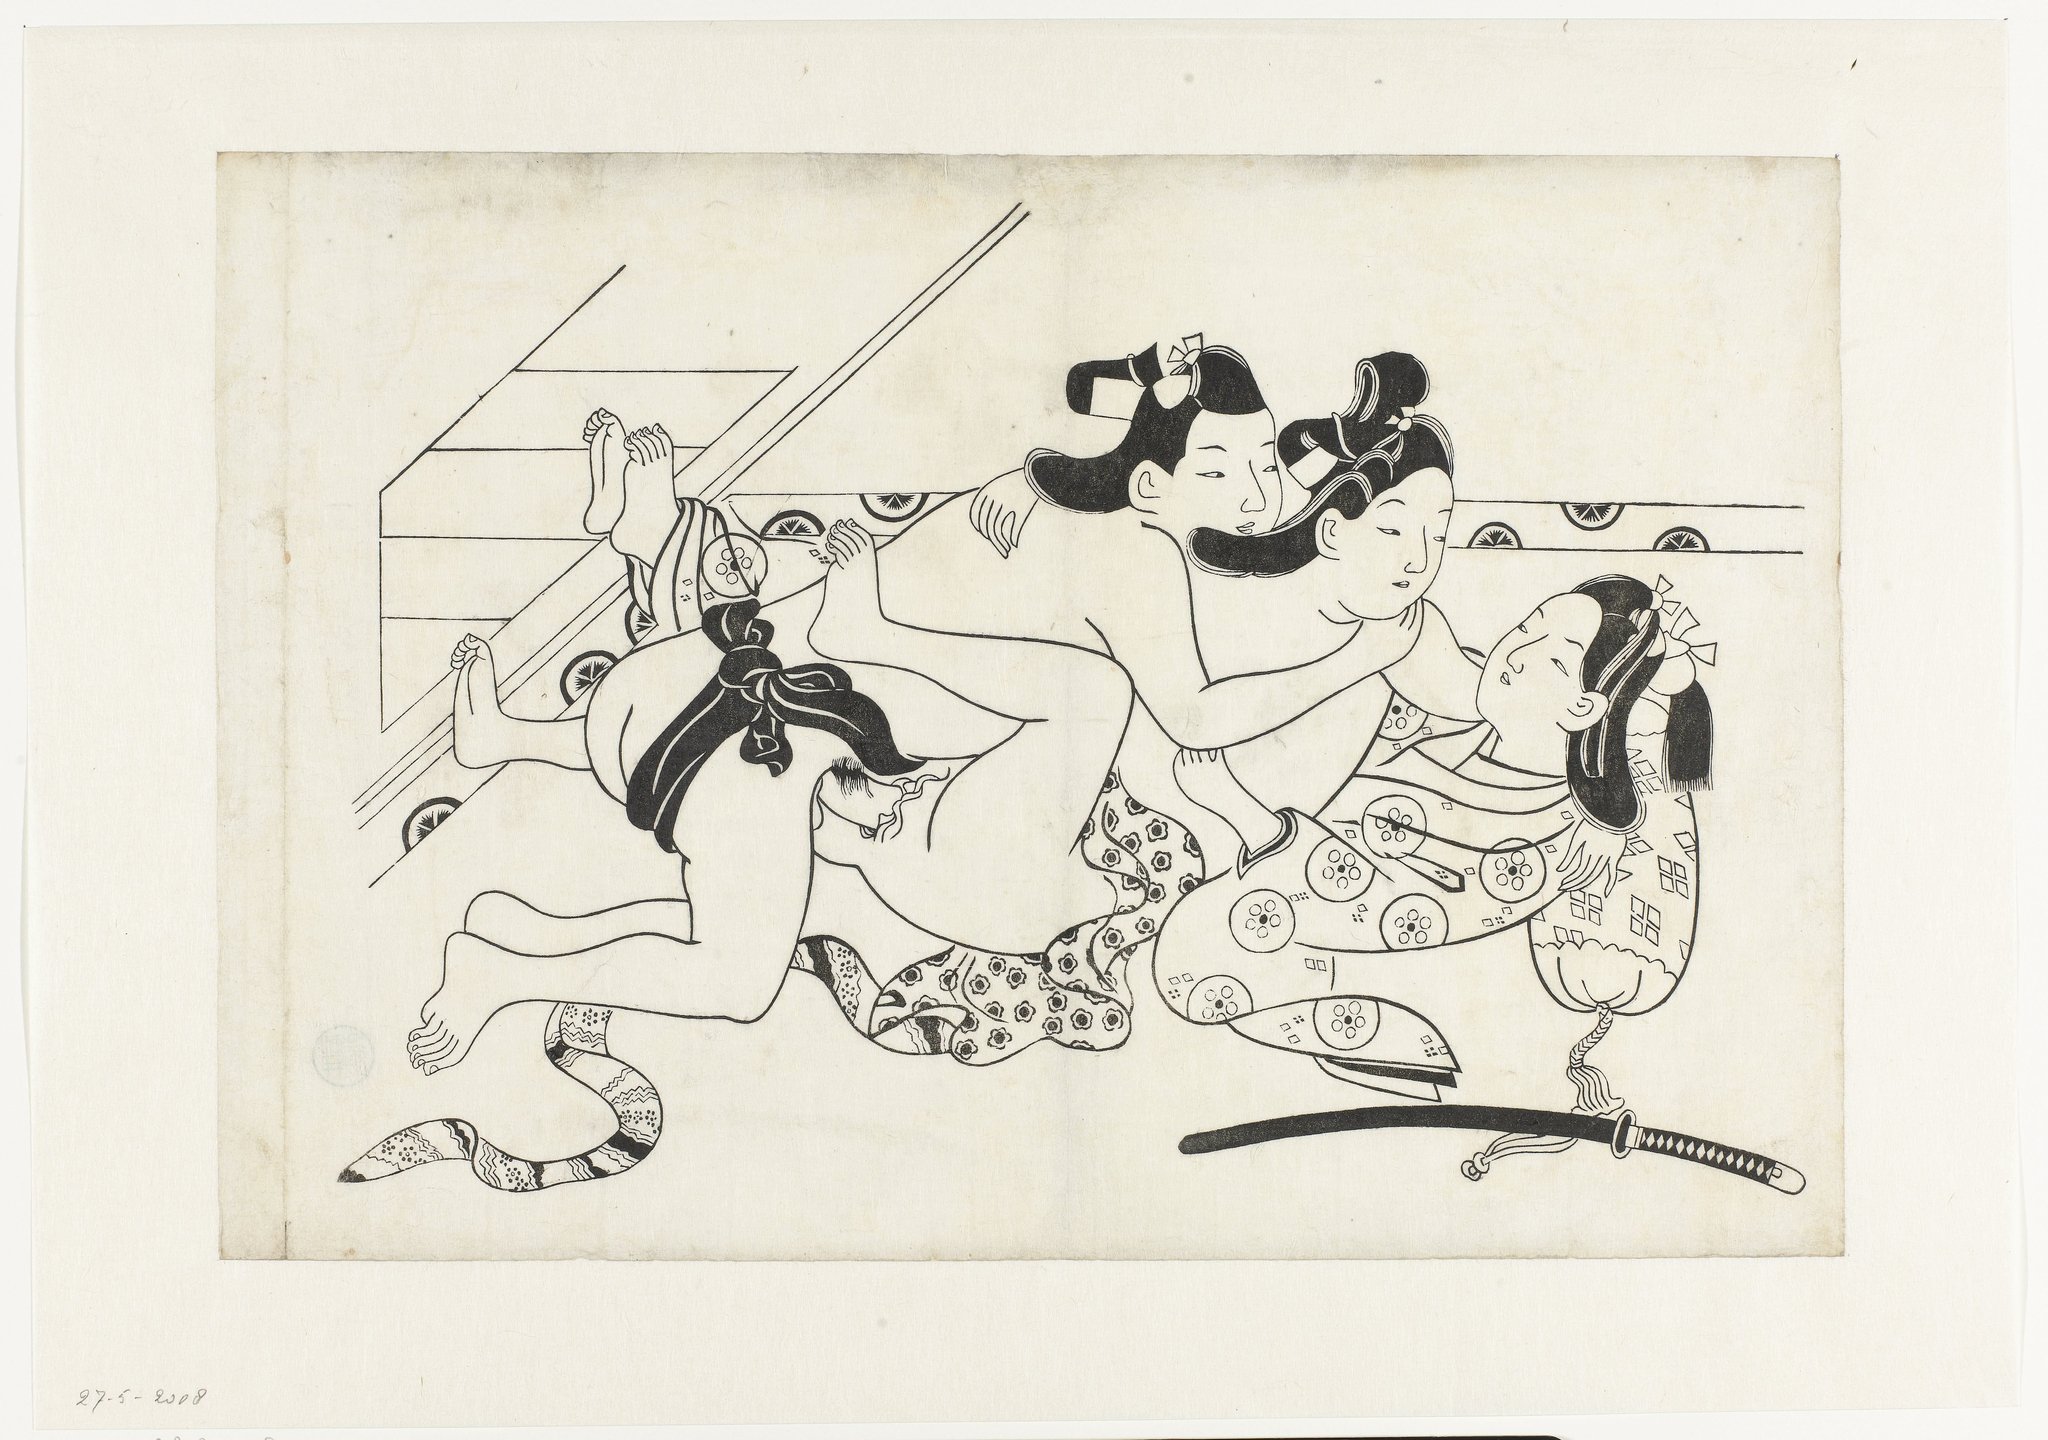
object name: print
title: Erotische voorstelling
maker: hishikawa moroshige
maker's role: print maker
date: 1678-1698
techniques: woodcut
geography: edo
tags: group-sex, man and woman cohabiting, hacking and thrusting weapons: sword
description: Een man vrijend met twee vrouwen. Naast hen ligt een zwaard.